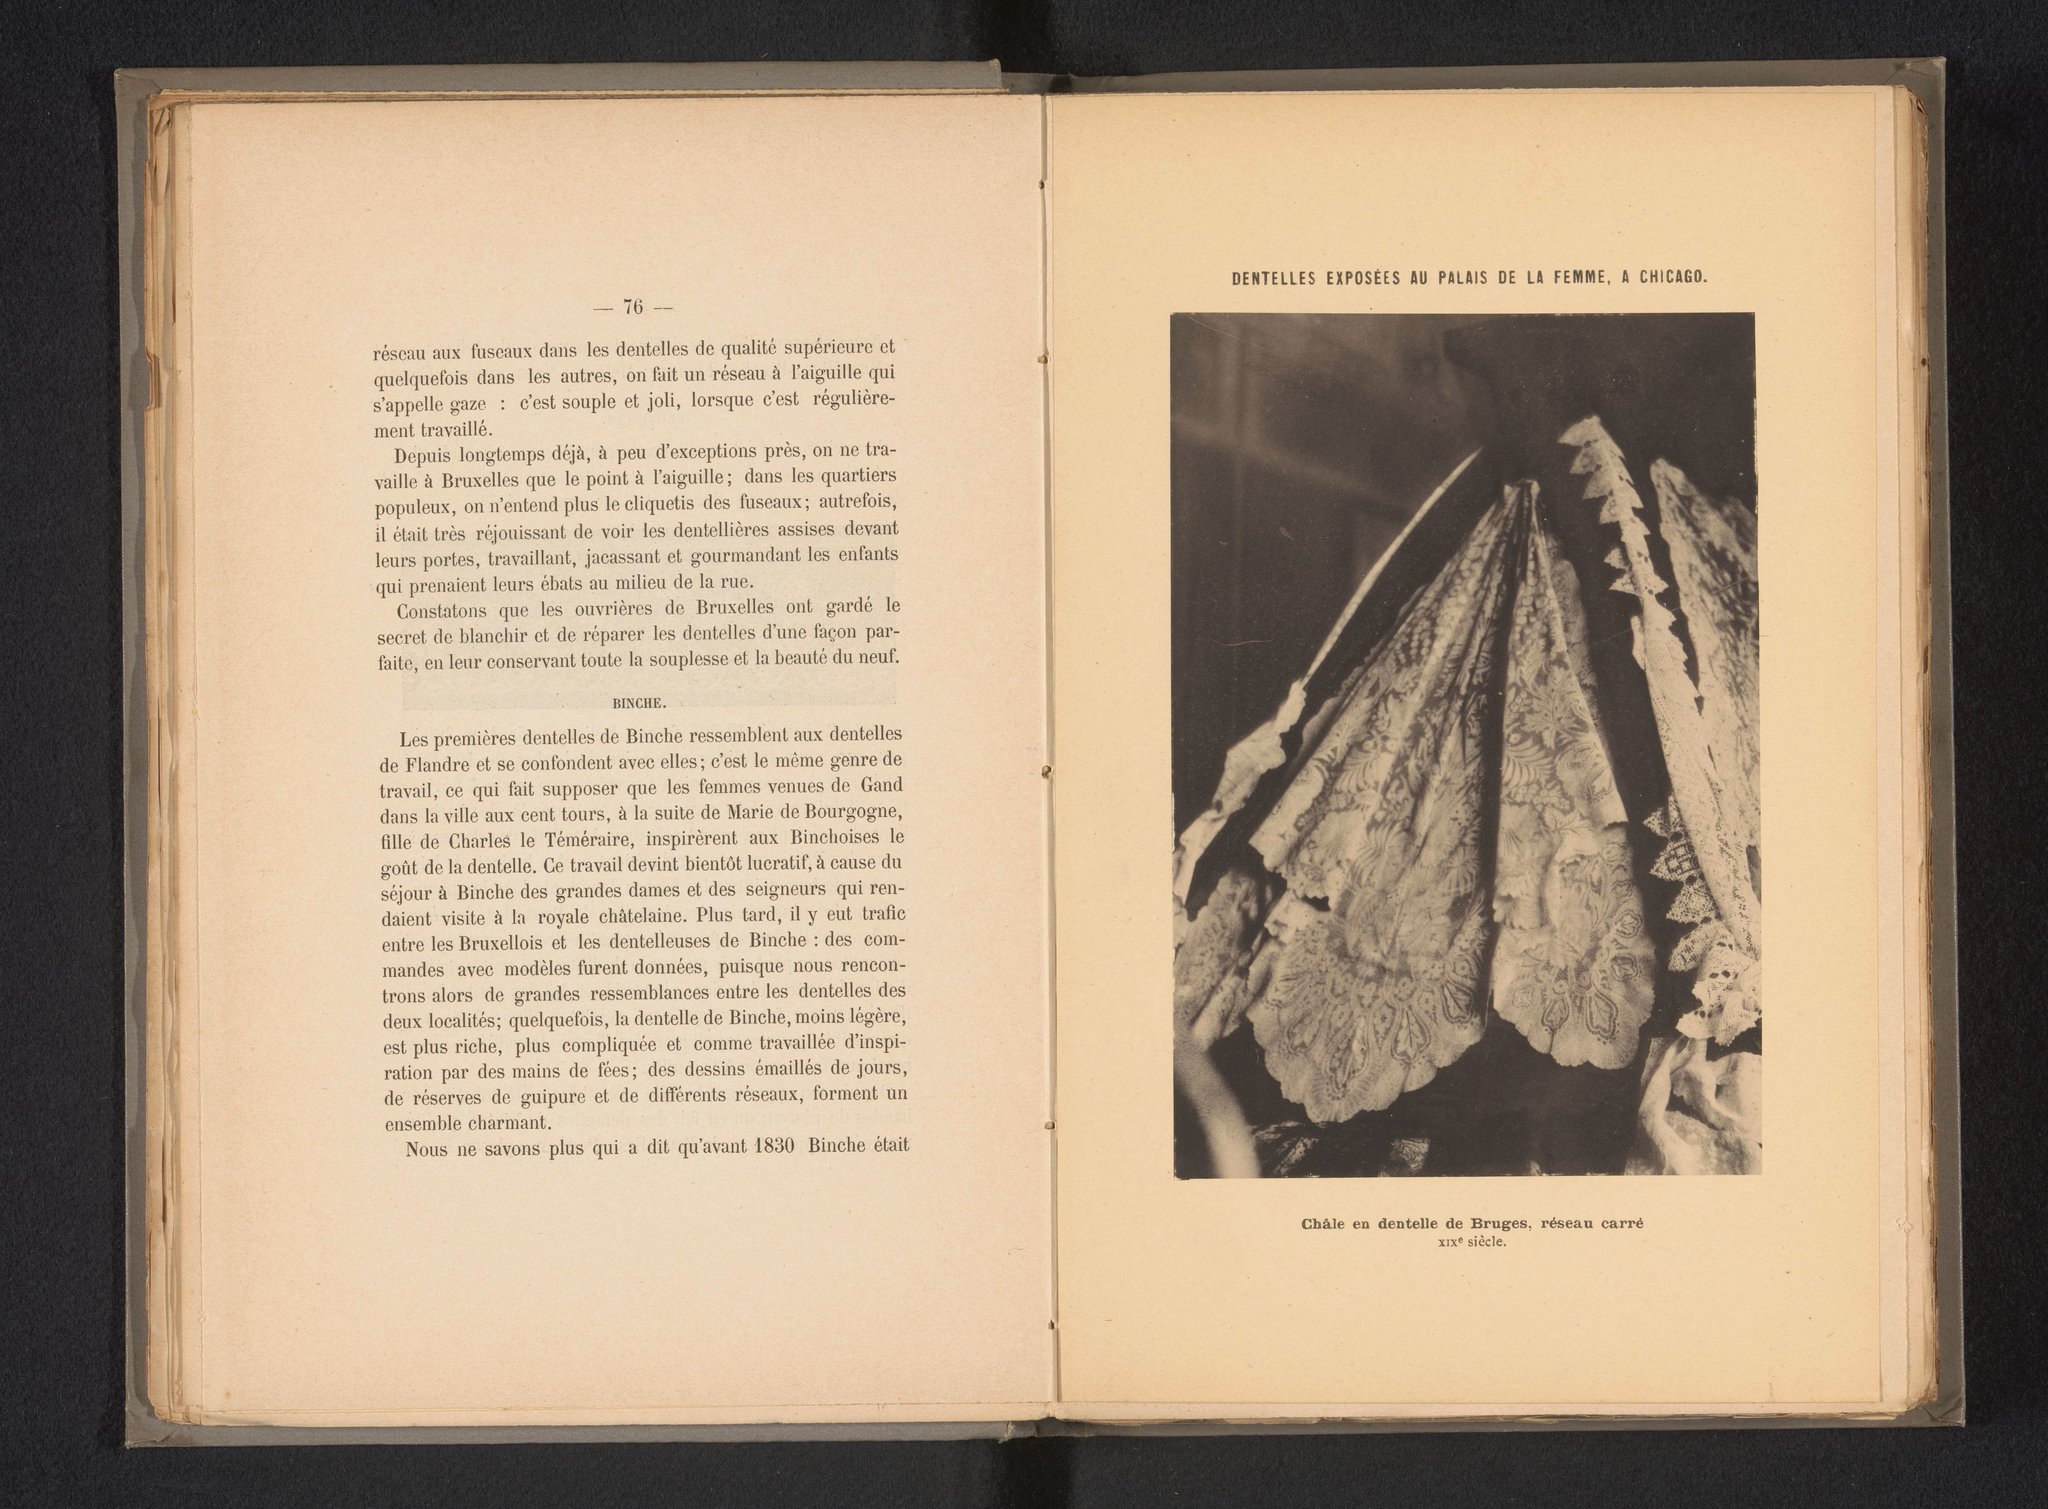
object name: photomechanical print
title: Sjaal van kant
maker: Anonymous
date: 1888-1893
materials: paper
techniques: photograph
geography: chicago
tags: accessories (~ clothing), lace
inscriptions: inscription: ‘XIXe siècle.’